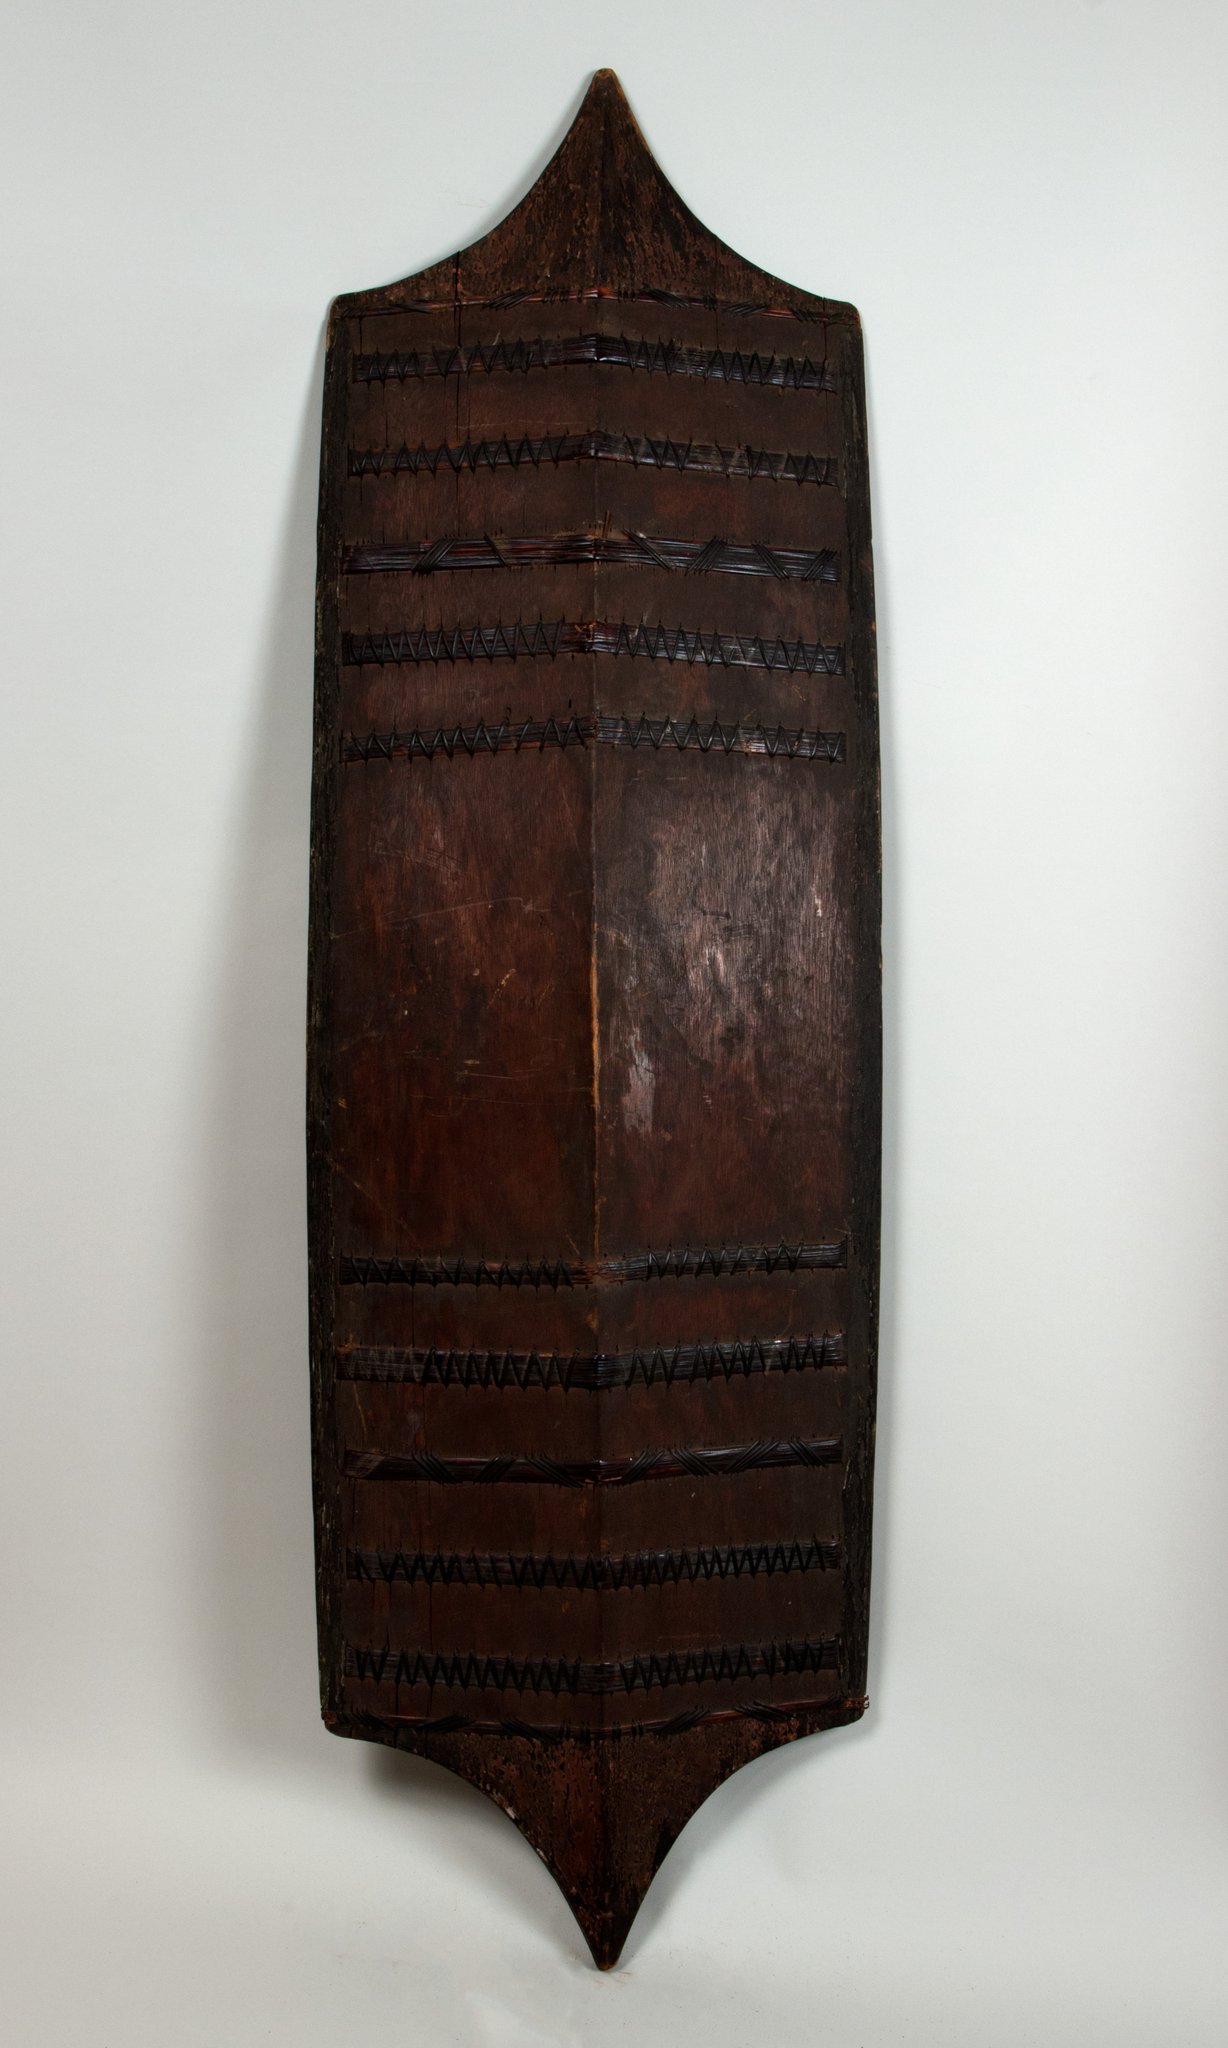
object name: shield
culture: bornean or dyak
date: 1701-1900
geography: borneo